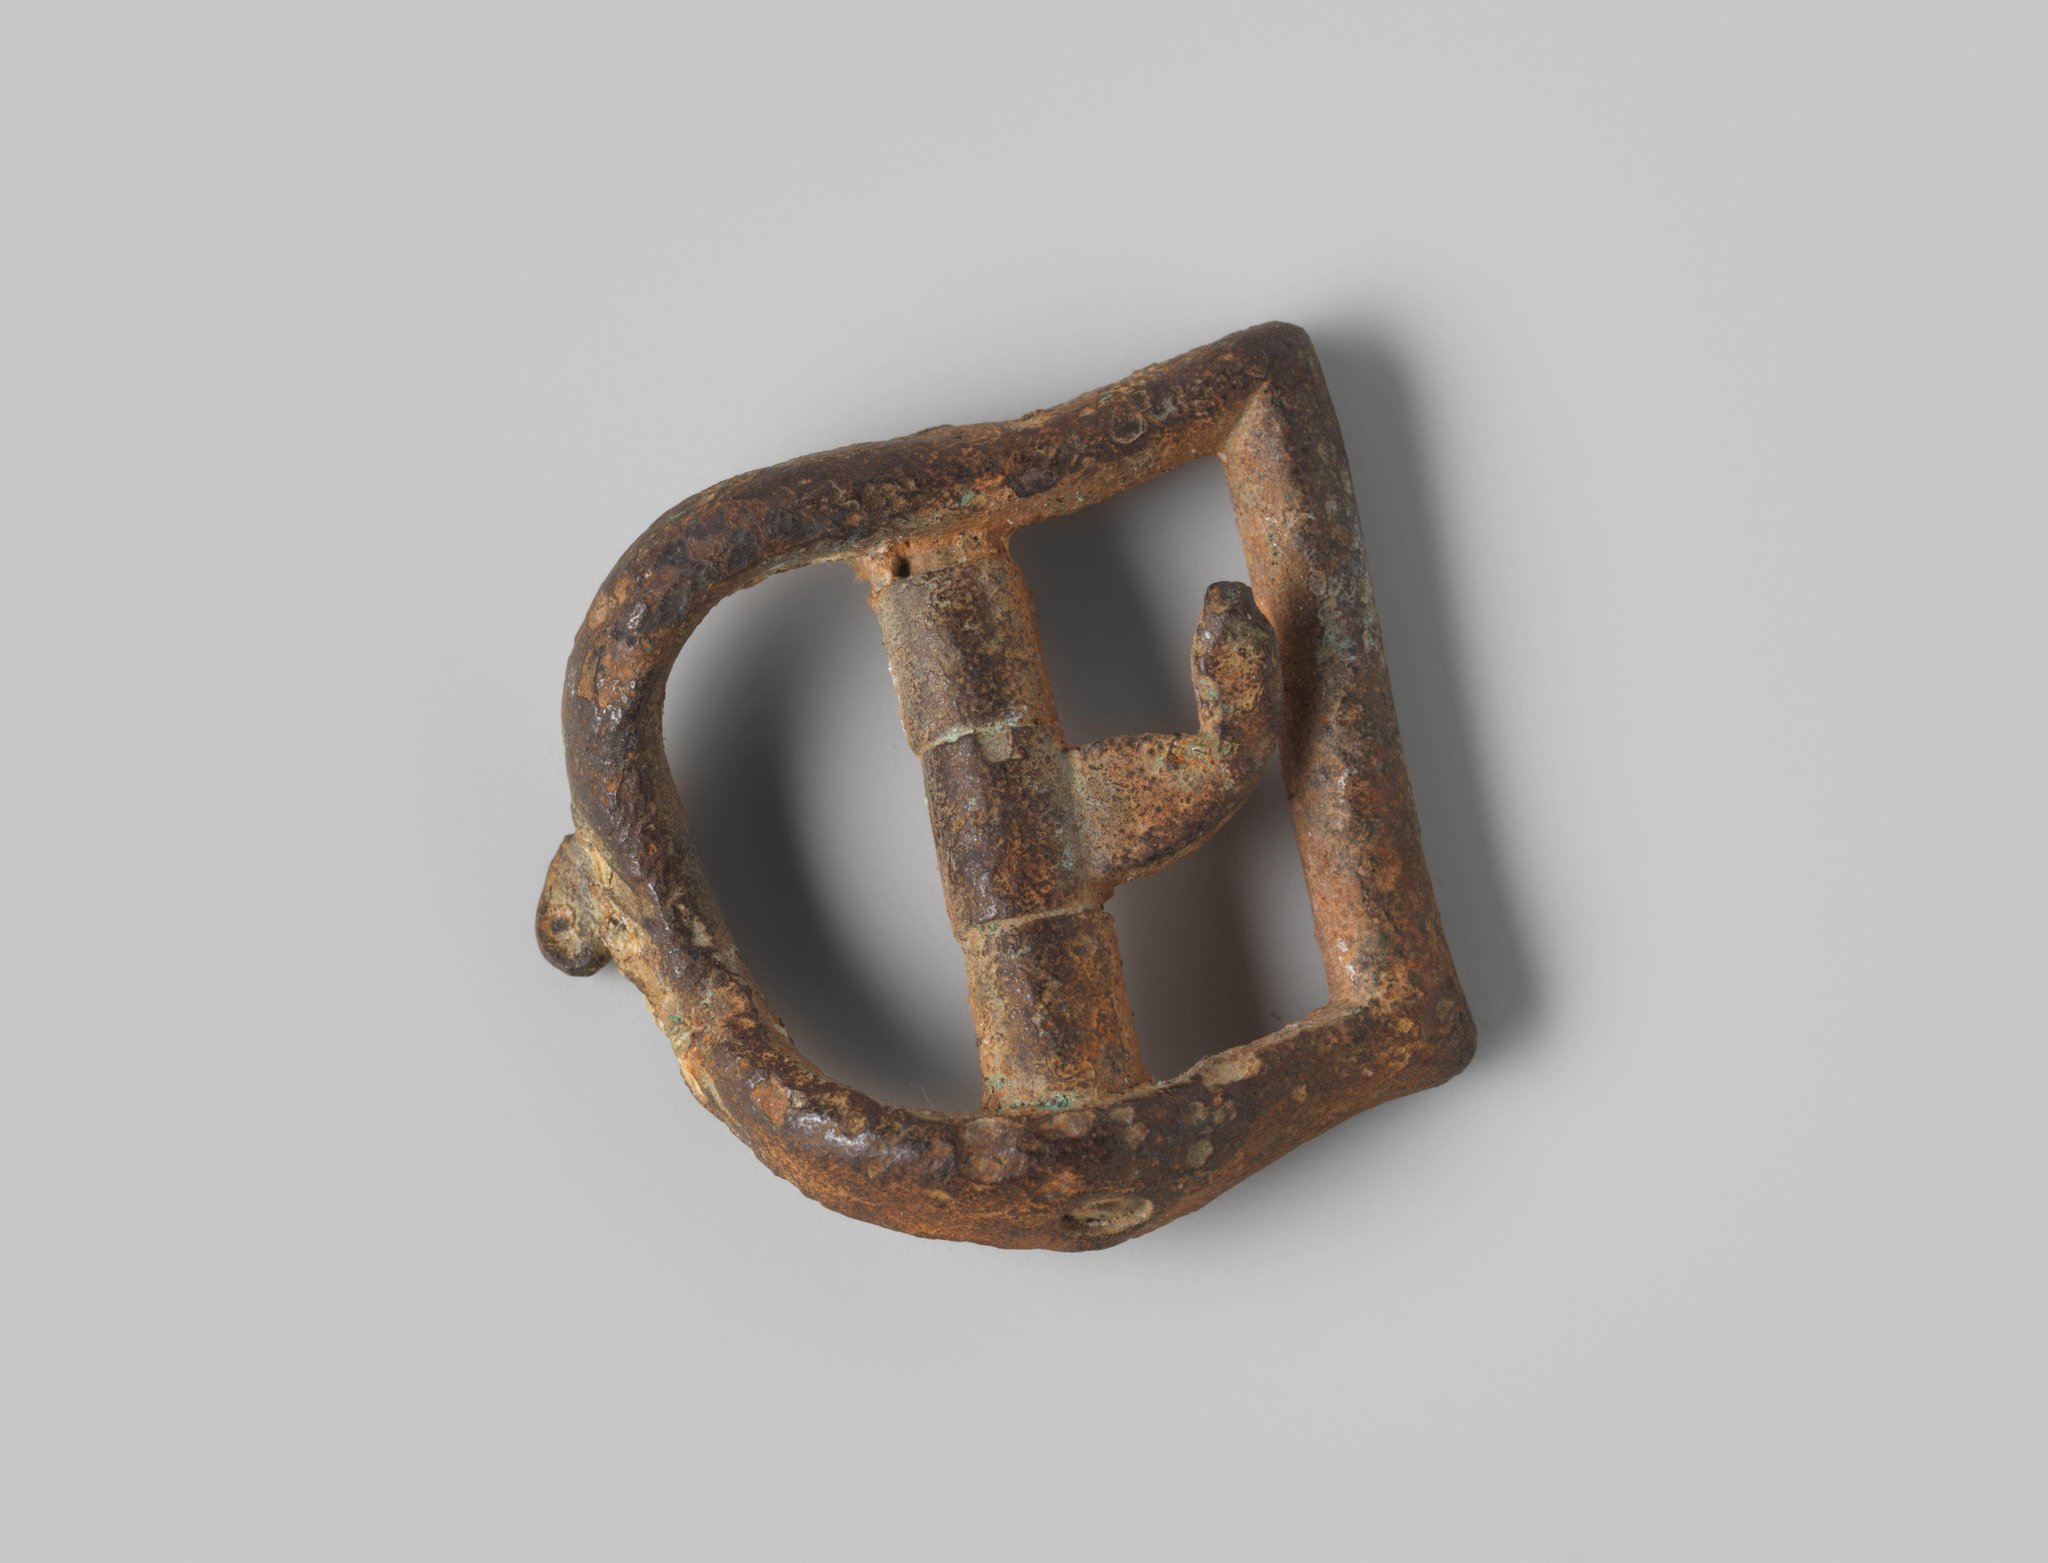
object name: knee buckle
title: Kniegesp uit het wrak van de Oost-Indiëvaarder Hollandia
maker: Anonymous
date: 1700-1743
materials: copper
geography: netherlands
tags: verenigde oostindische compagnie, hollandia (schip), annet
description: Buckle, chape buckle, knee buckle, D-shaped; fragm: ring, plain, spindle, tongue, loop broken off.